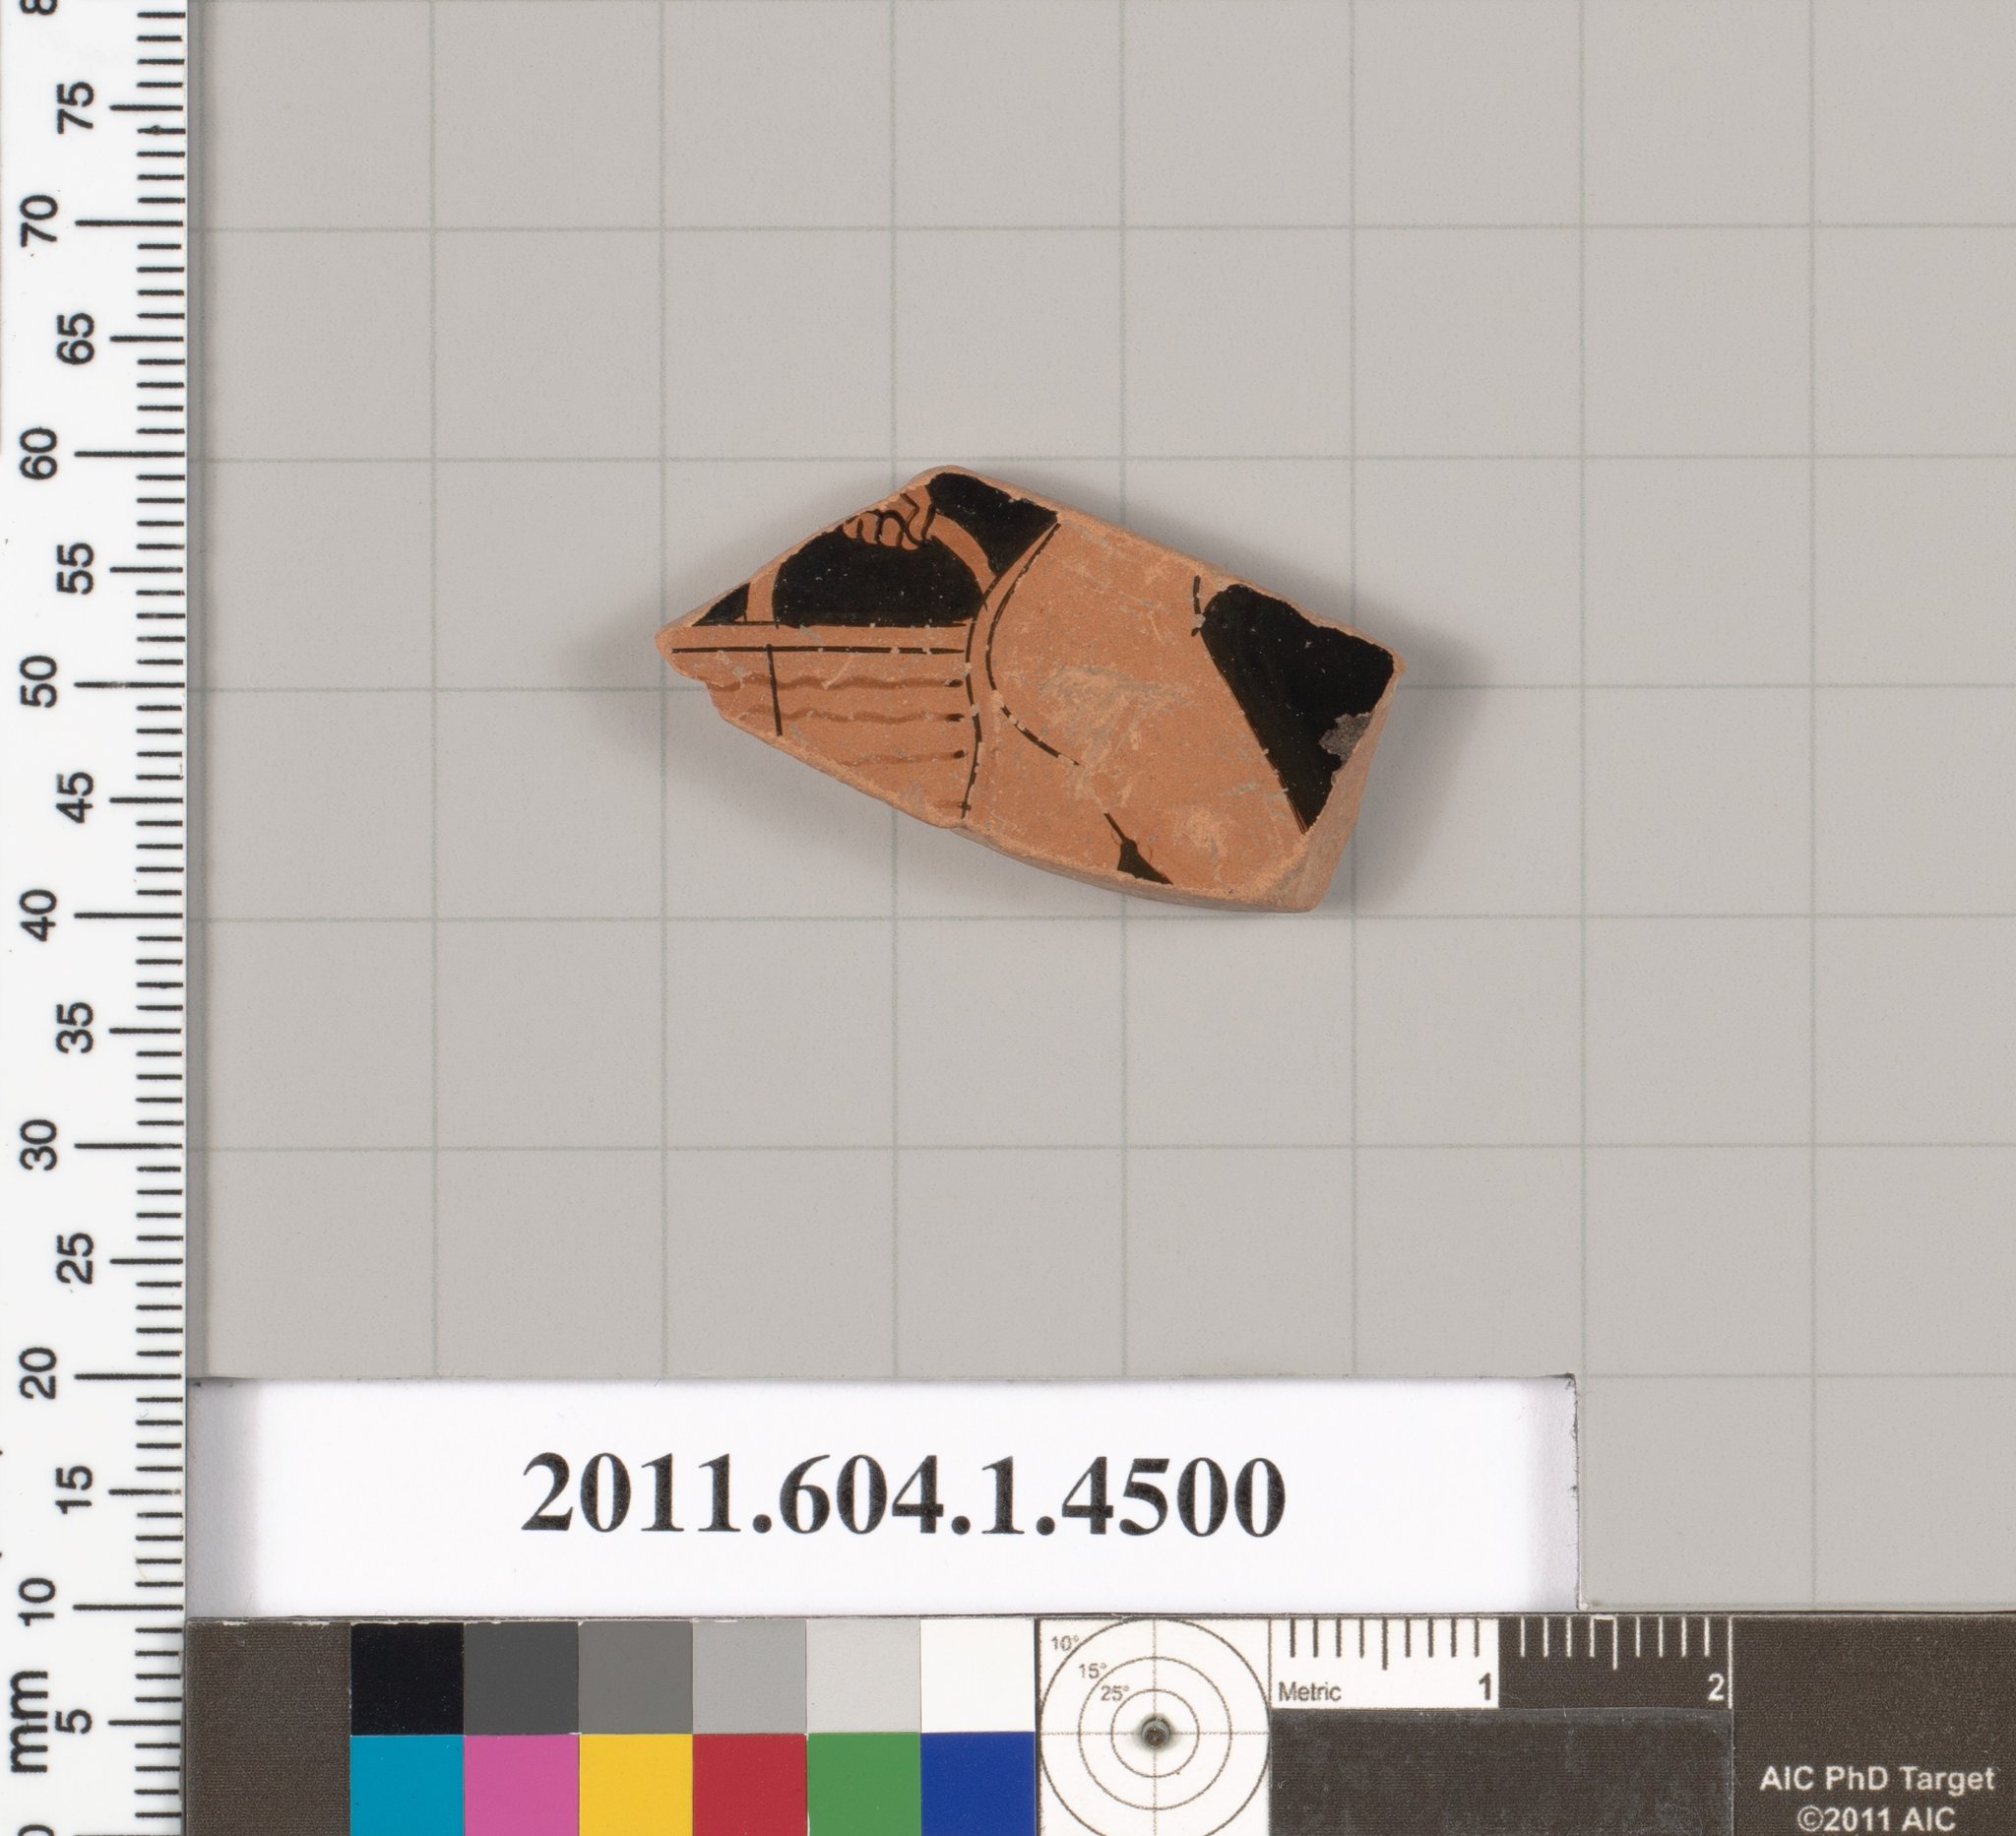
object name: kylix fragment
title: Terracotta fragment of a kylix (drinking cup)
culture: greek, attic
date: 490-470 BCE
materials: terracotta